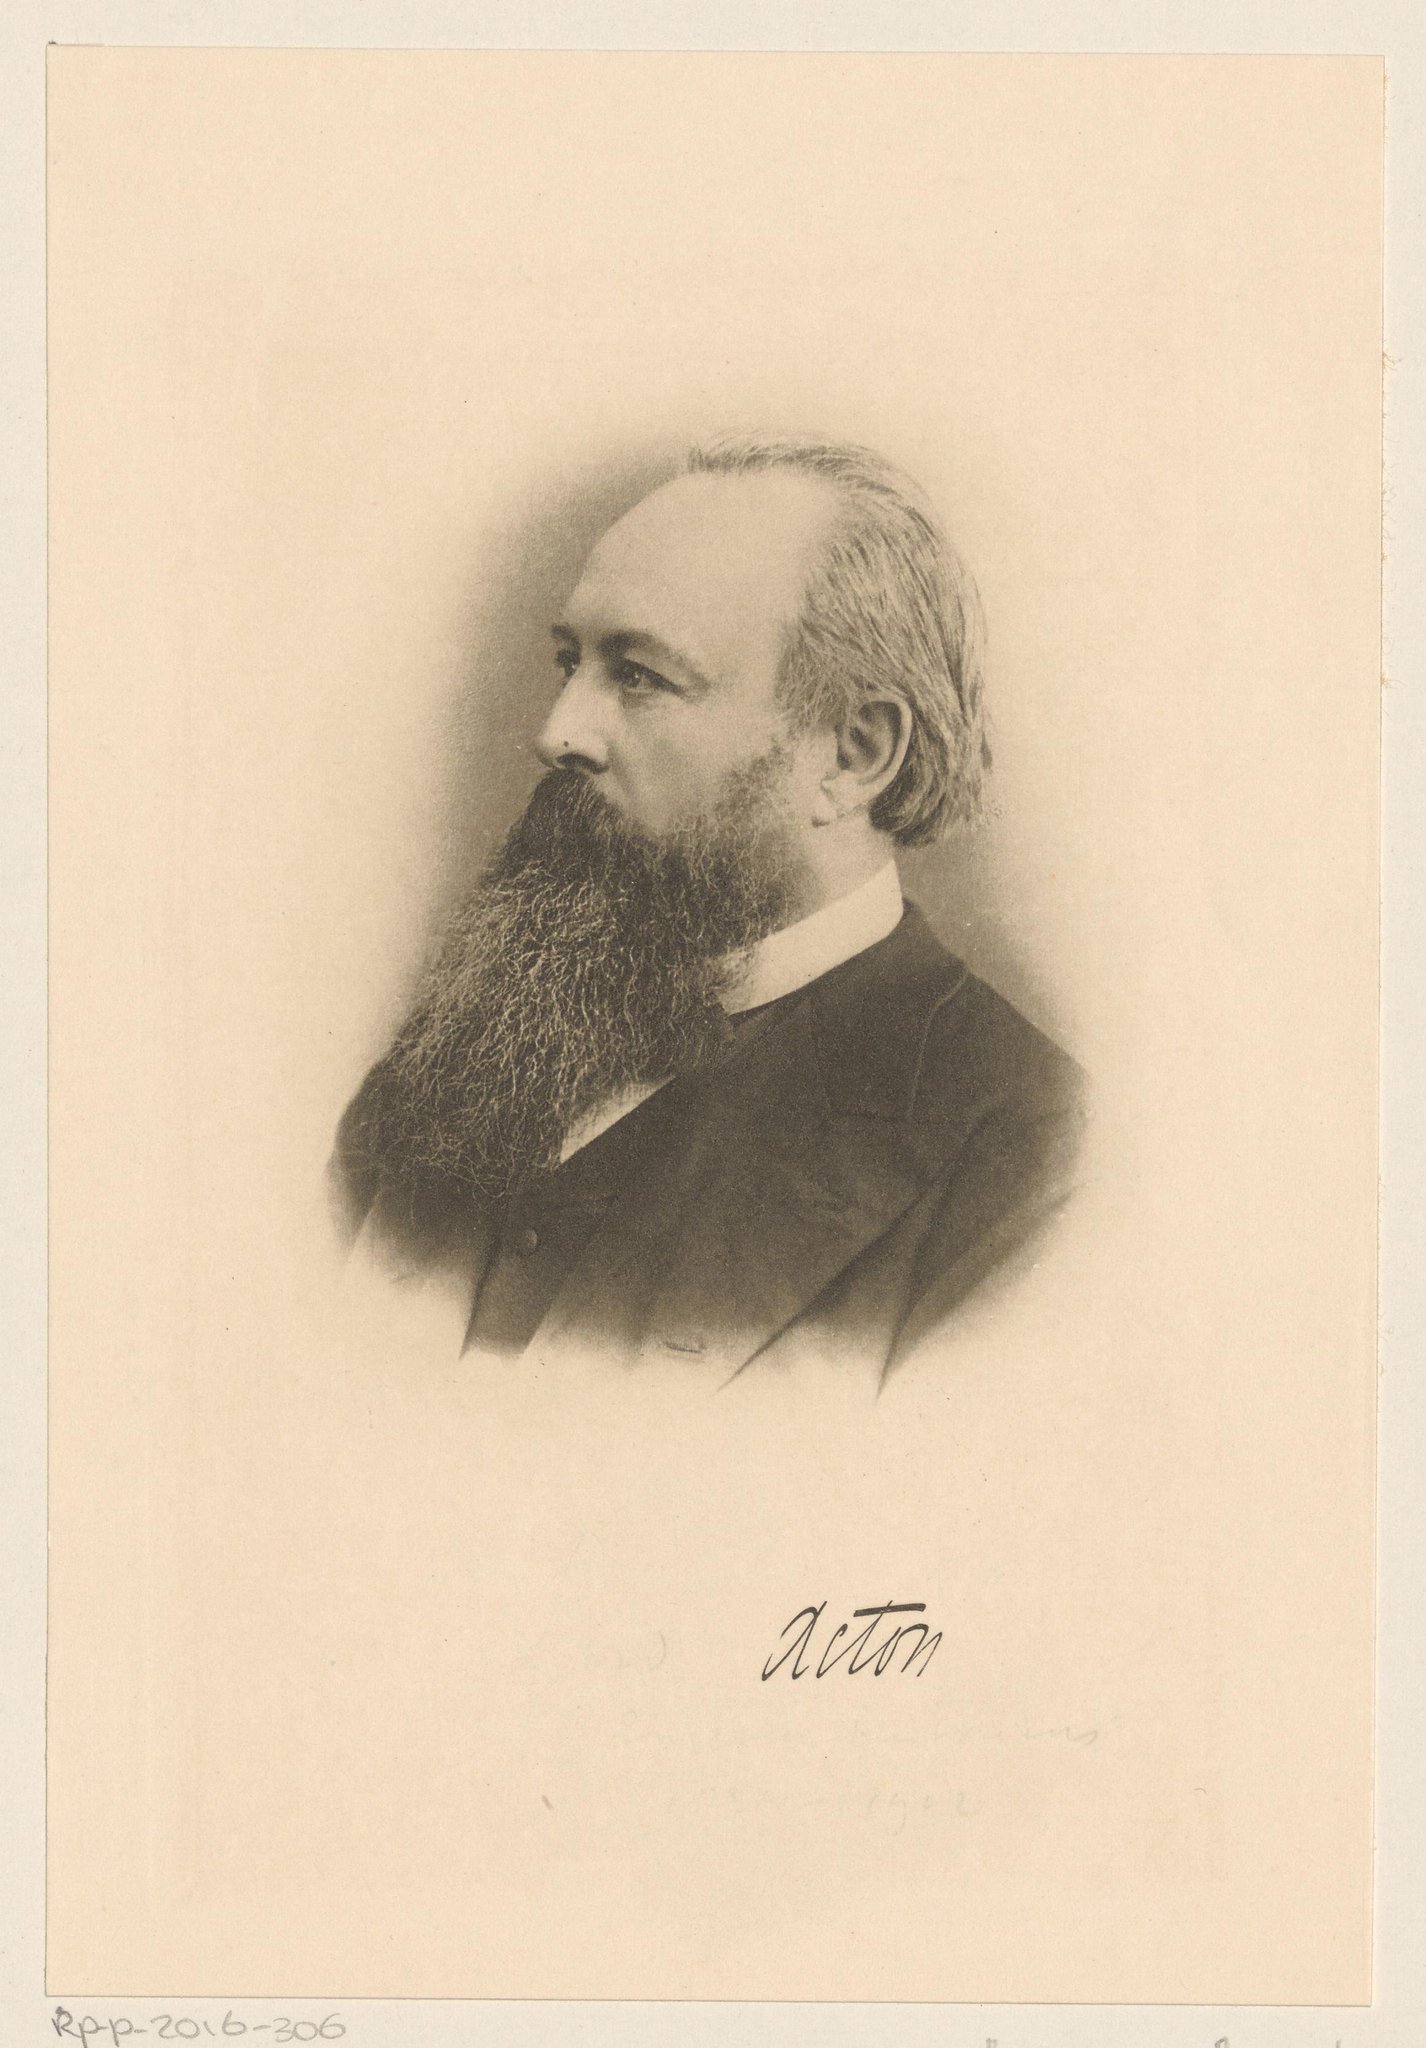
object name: photomechanical print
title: Portret van John Dalberg-Acton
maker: Anonymous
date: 1875-1902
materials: paper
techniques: photograph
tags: politician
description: Portret van John Dalberg-Acton. In de ondermarge zijn naam.